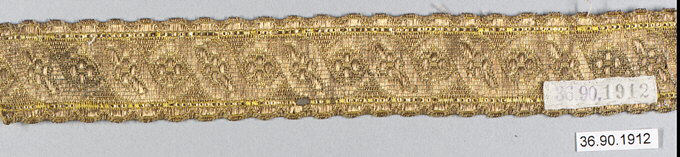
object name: galloon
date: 1767-1833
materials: metal thread, silk